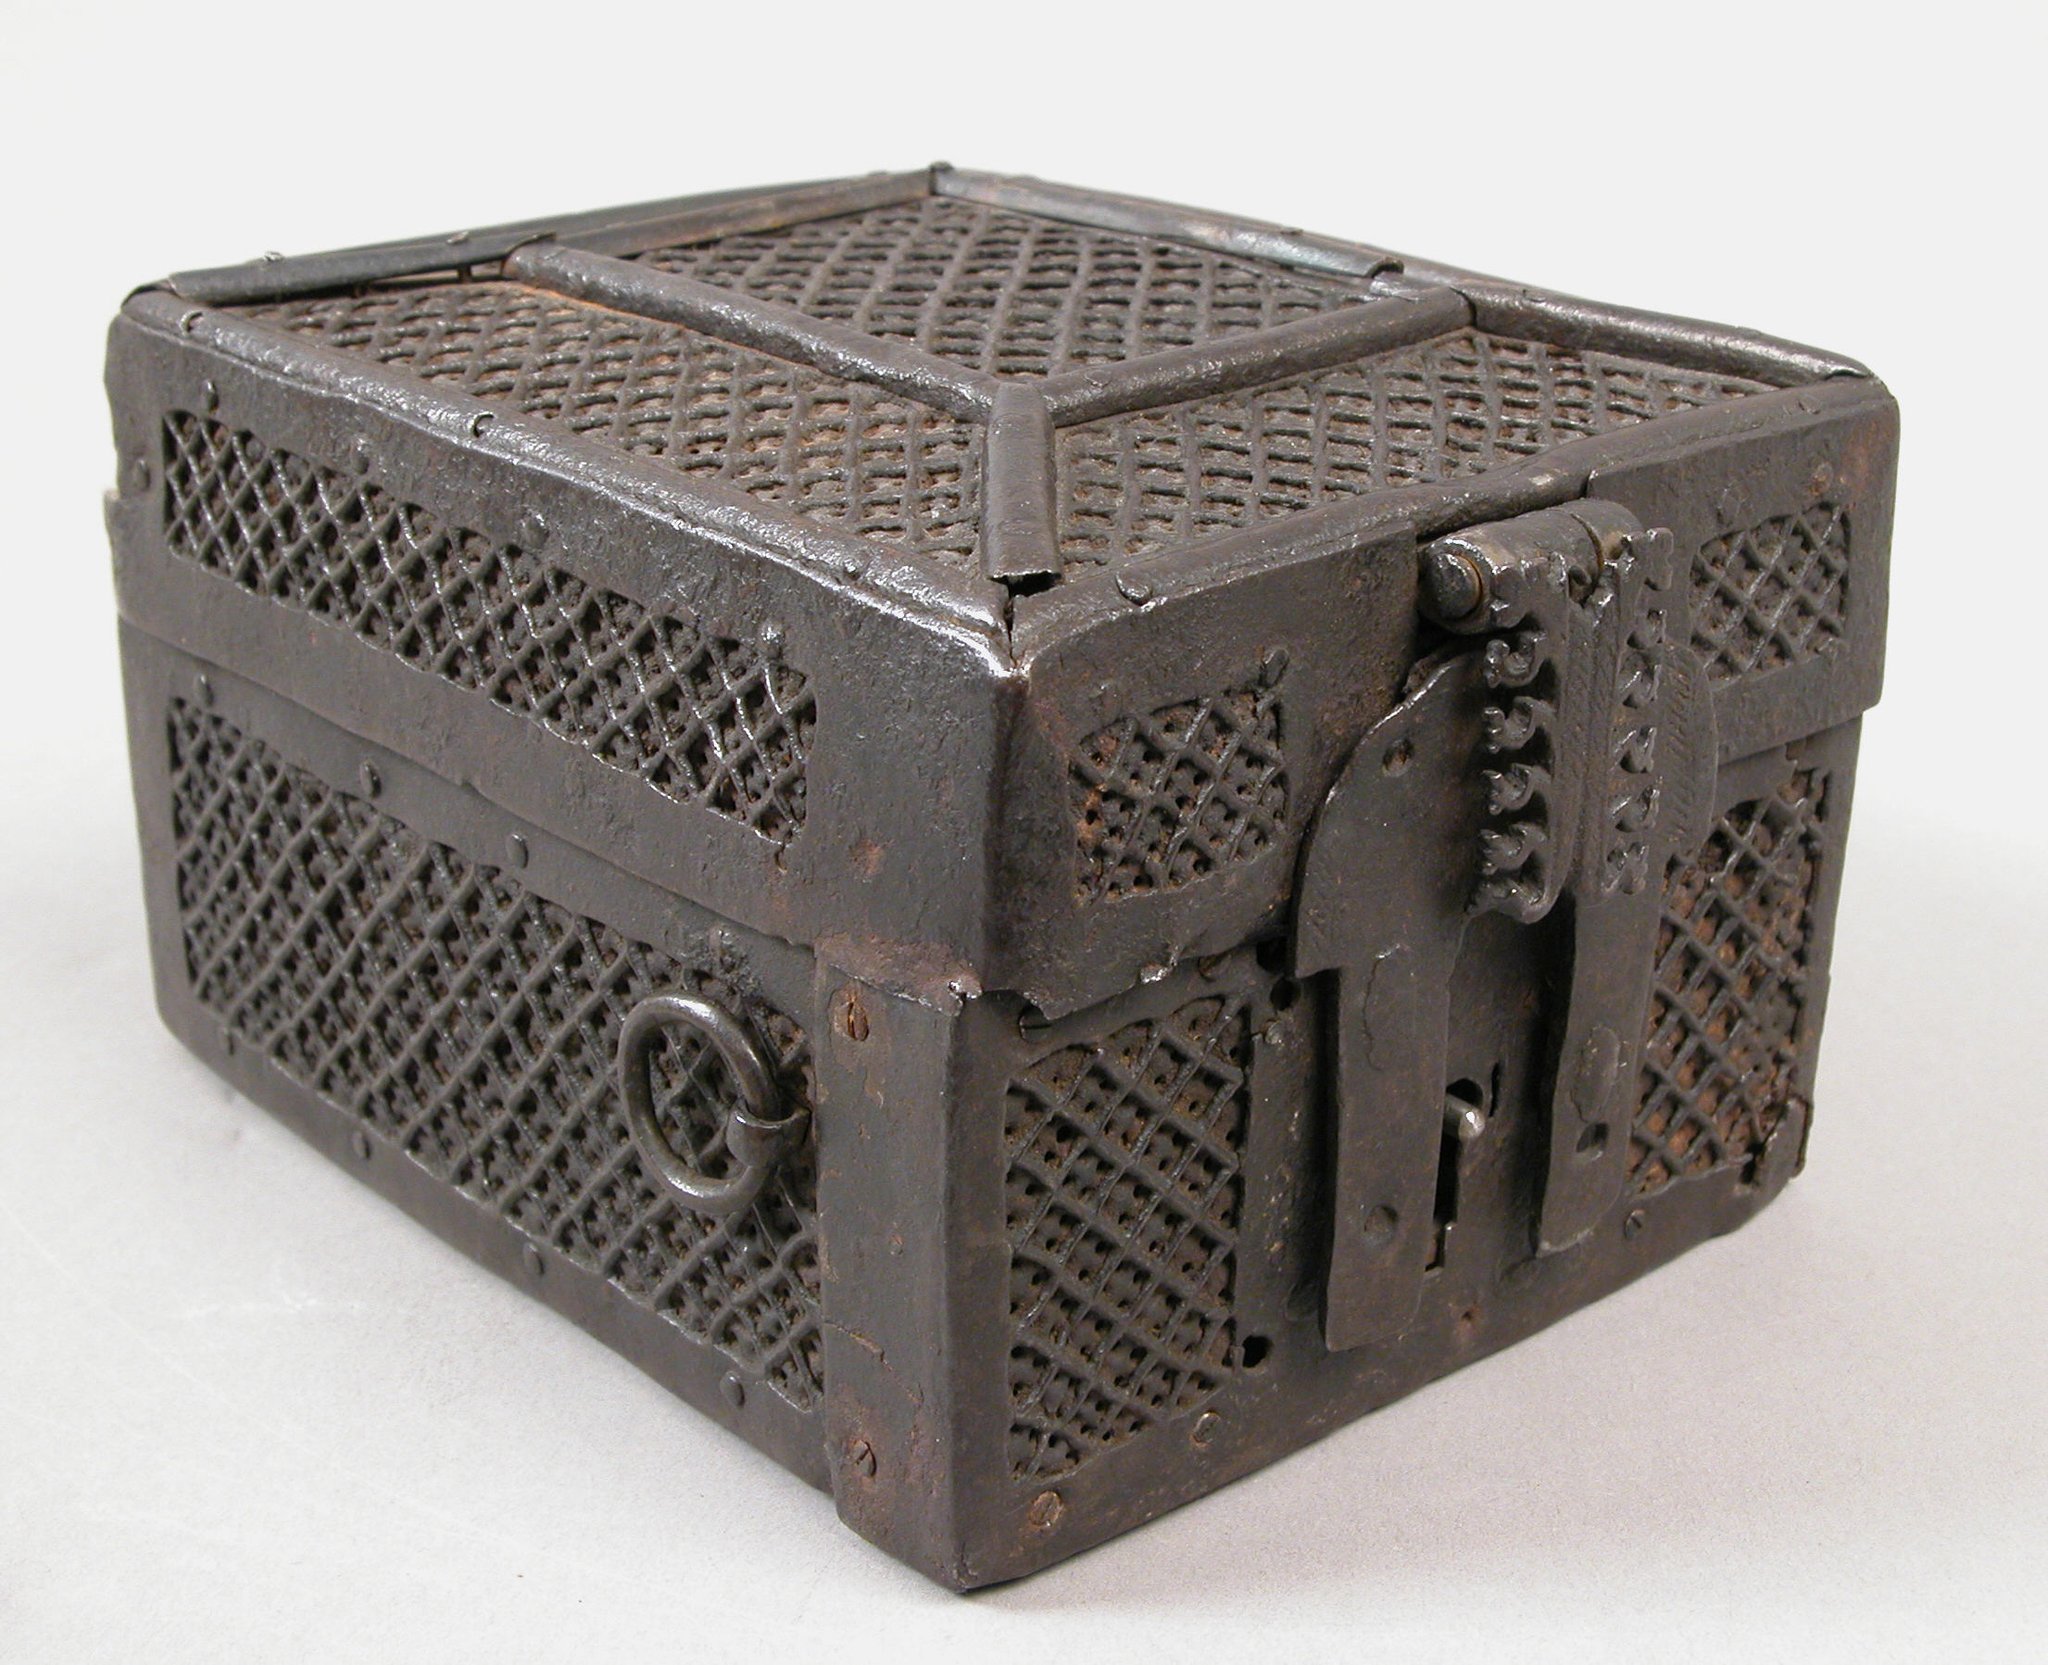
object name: box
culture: spanish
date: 1501-1600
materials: iron, wood